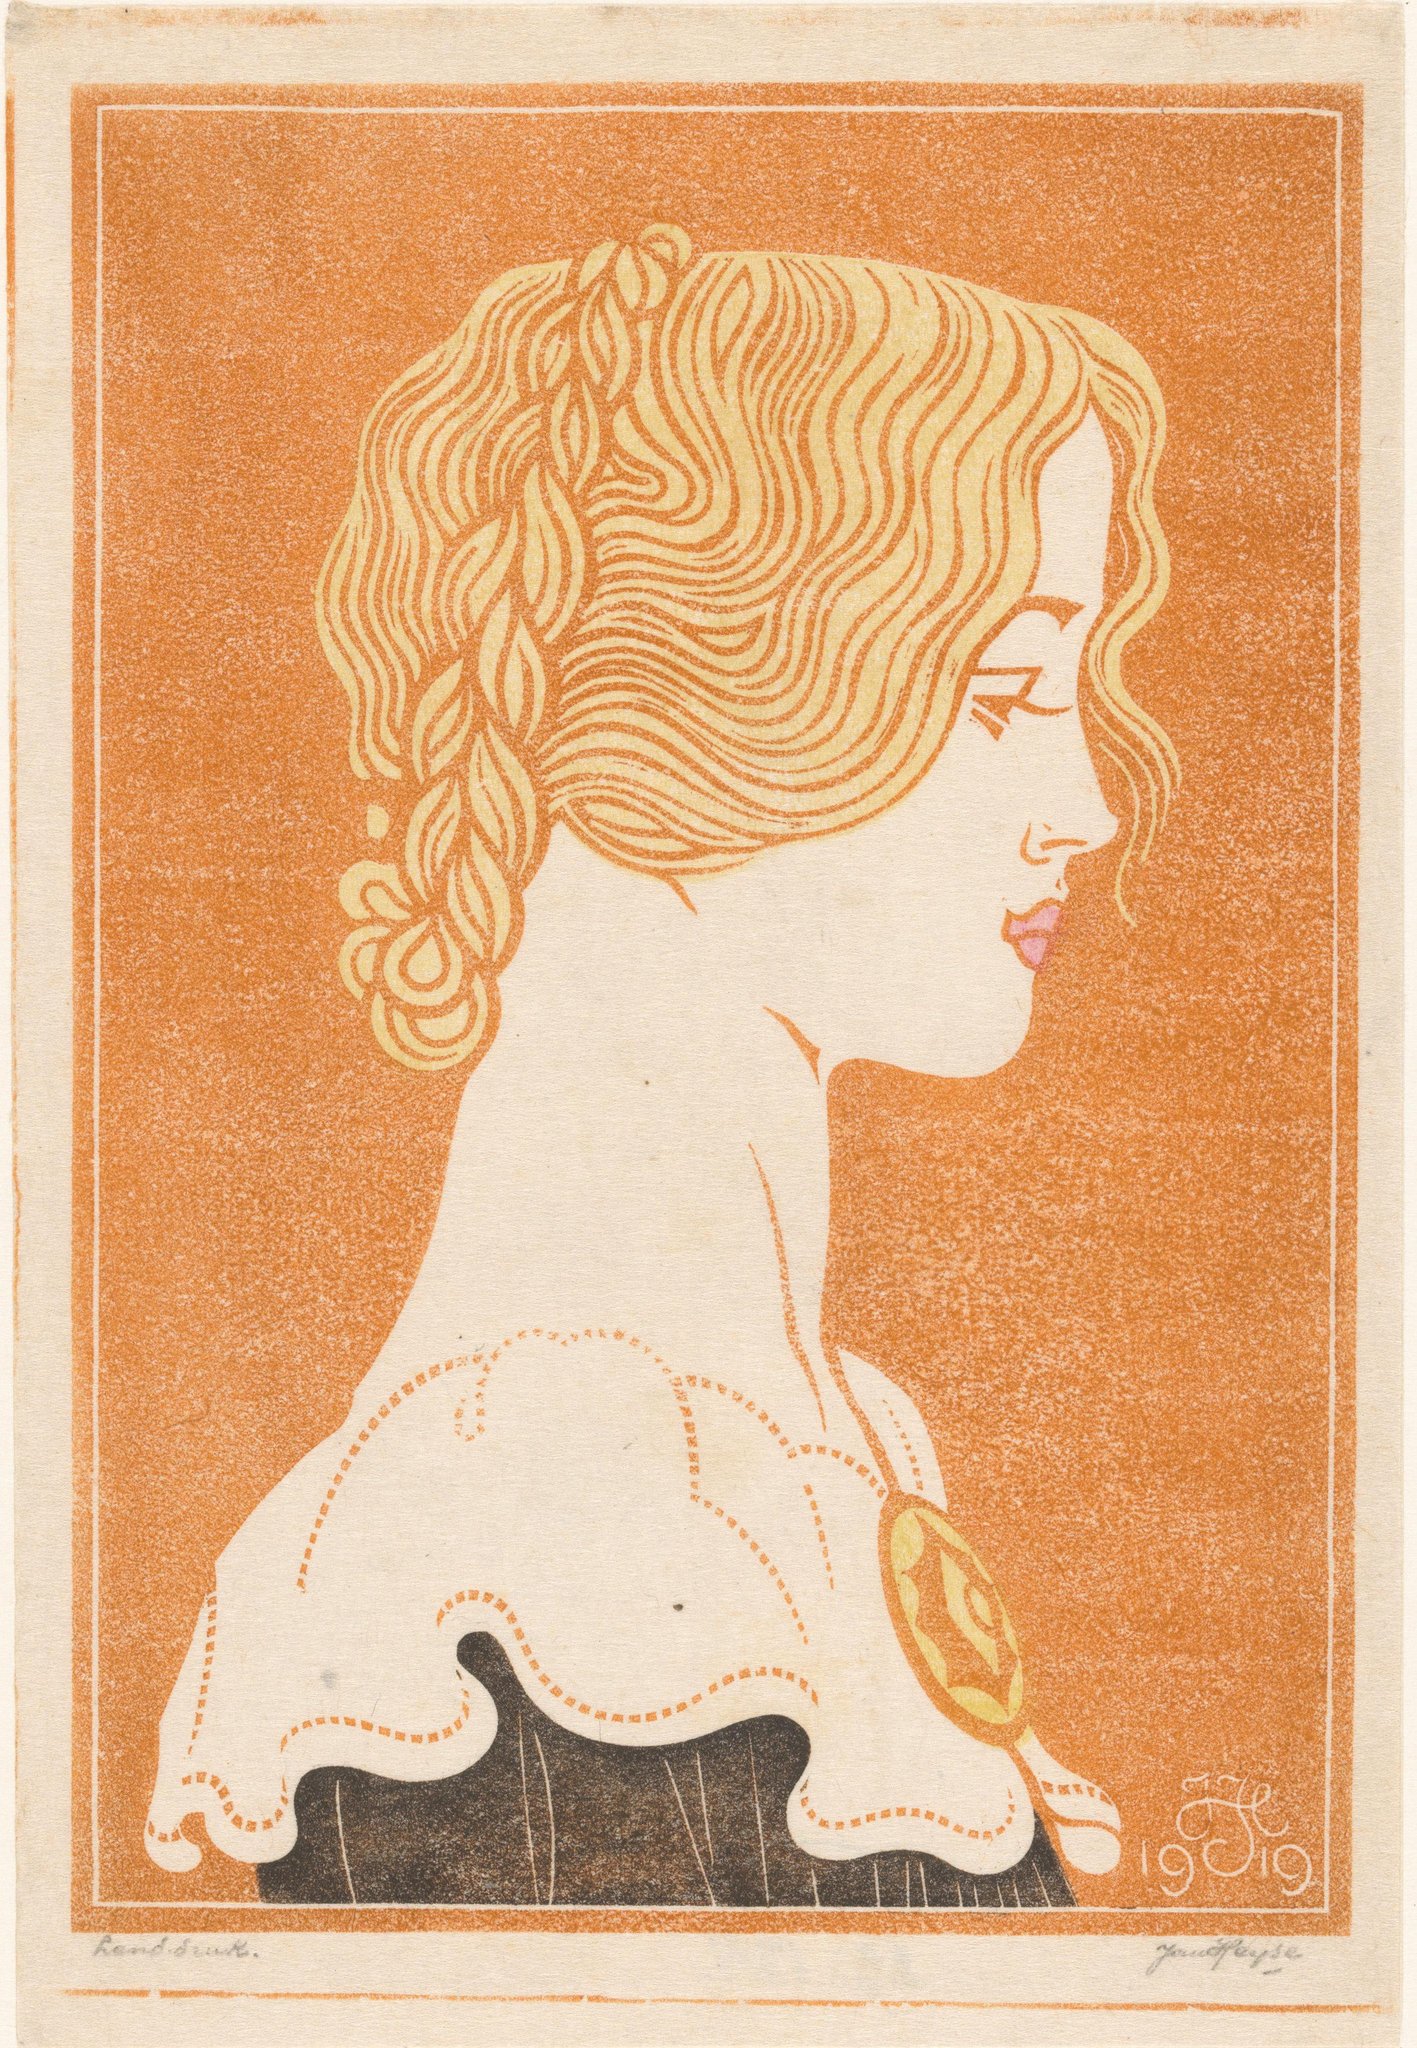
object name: print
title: Jonge vrouw en profil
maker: jan heyse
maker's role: painter, print maker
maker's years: 1882-1954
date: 1919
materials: paper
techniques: blind stamped, woodcut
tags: adolescent, young woman, maiden, styles of hairdress (with name) - aa - ~ women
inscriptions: collector's mark: Lugt 2228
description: De vrouw heeft een vlecht in het haar. Op haar kraag een ronde gesp.